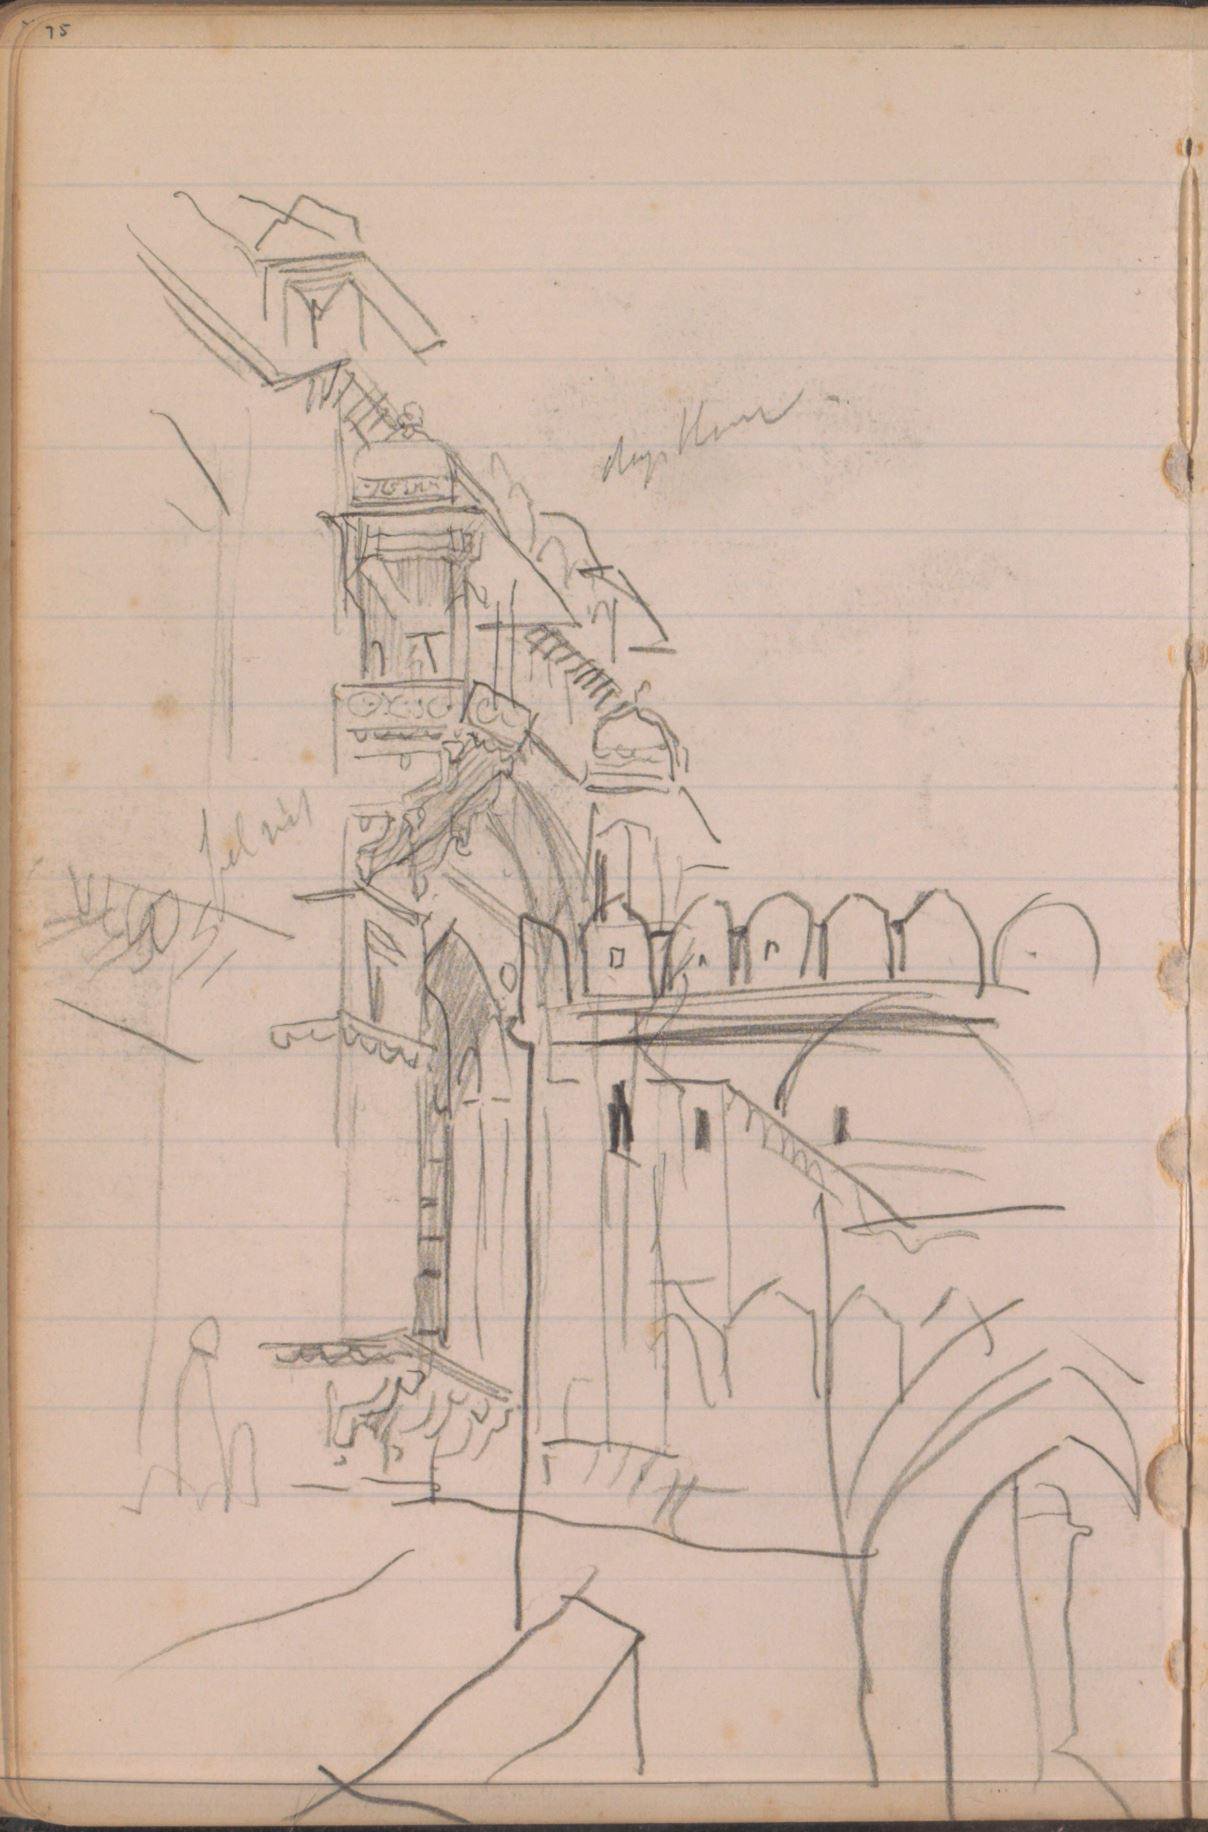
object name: sketchbook leaf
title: Straat met een poort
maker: marius bauer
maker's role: draughtsman, print maker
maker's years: 1867-1932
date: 1897-1898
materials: pencil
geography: india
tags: arch, archivolt ~ architecture, street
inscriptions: kleurnotitie, handgeschreven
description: Pagina 75 uit een schetsboek met 84 bladen.